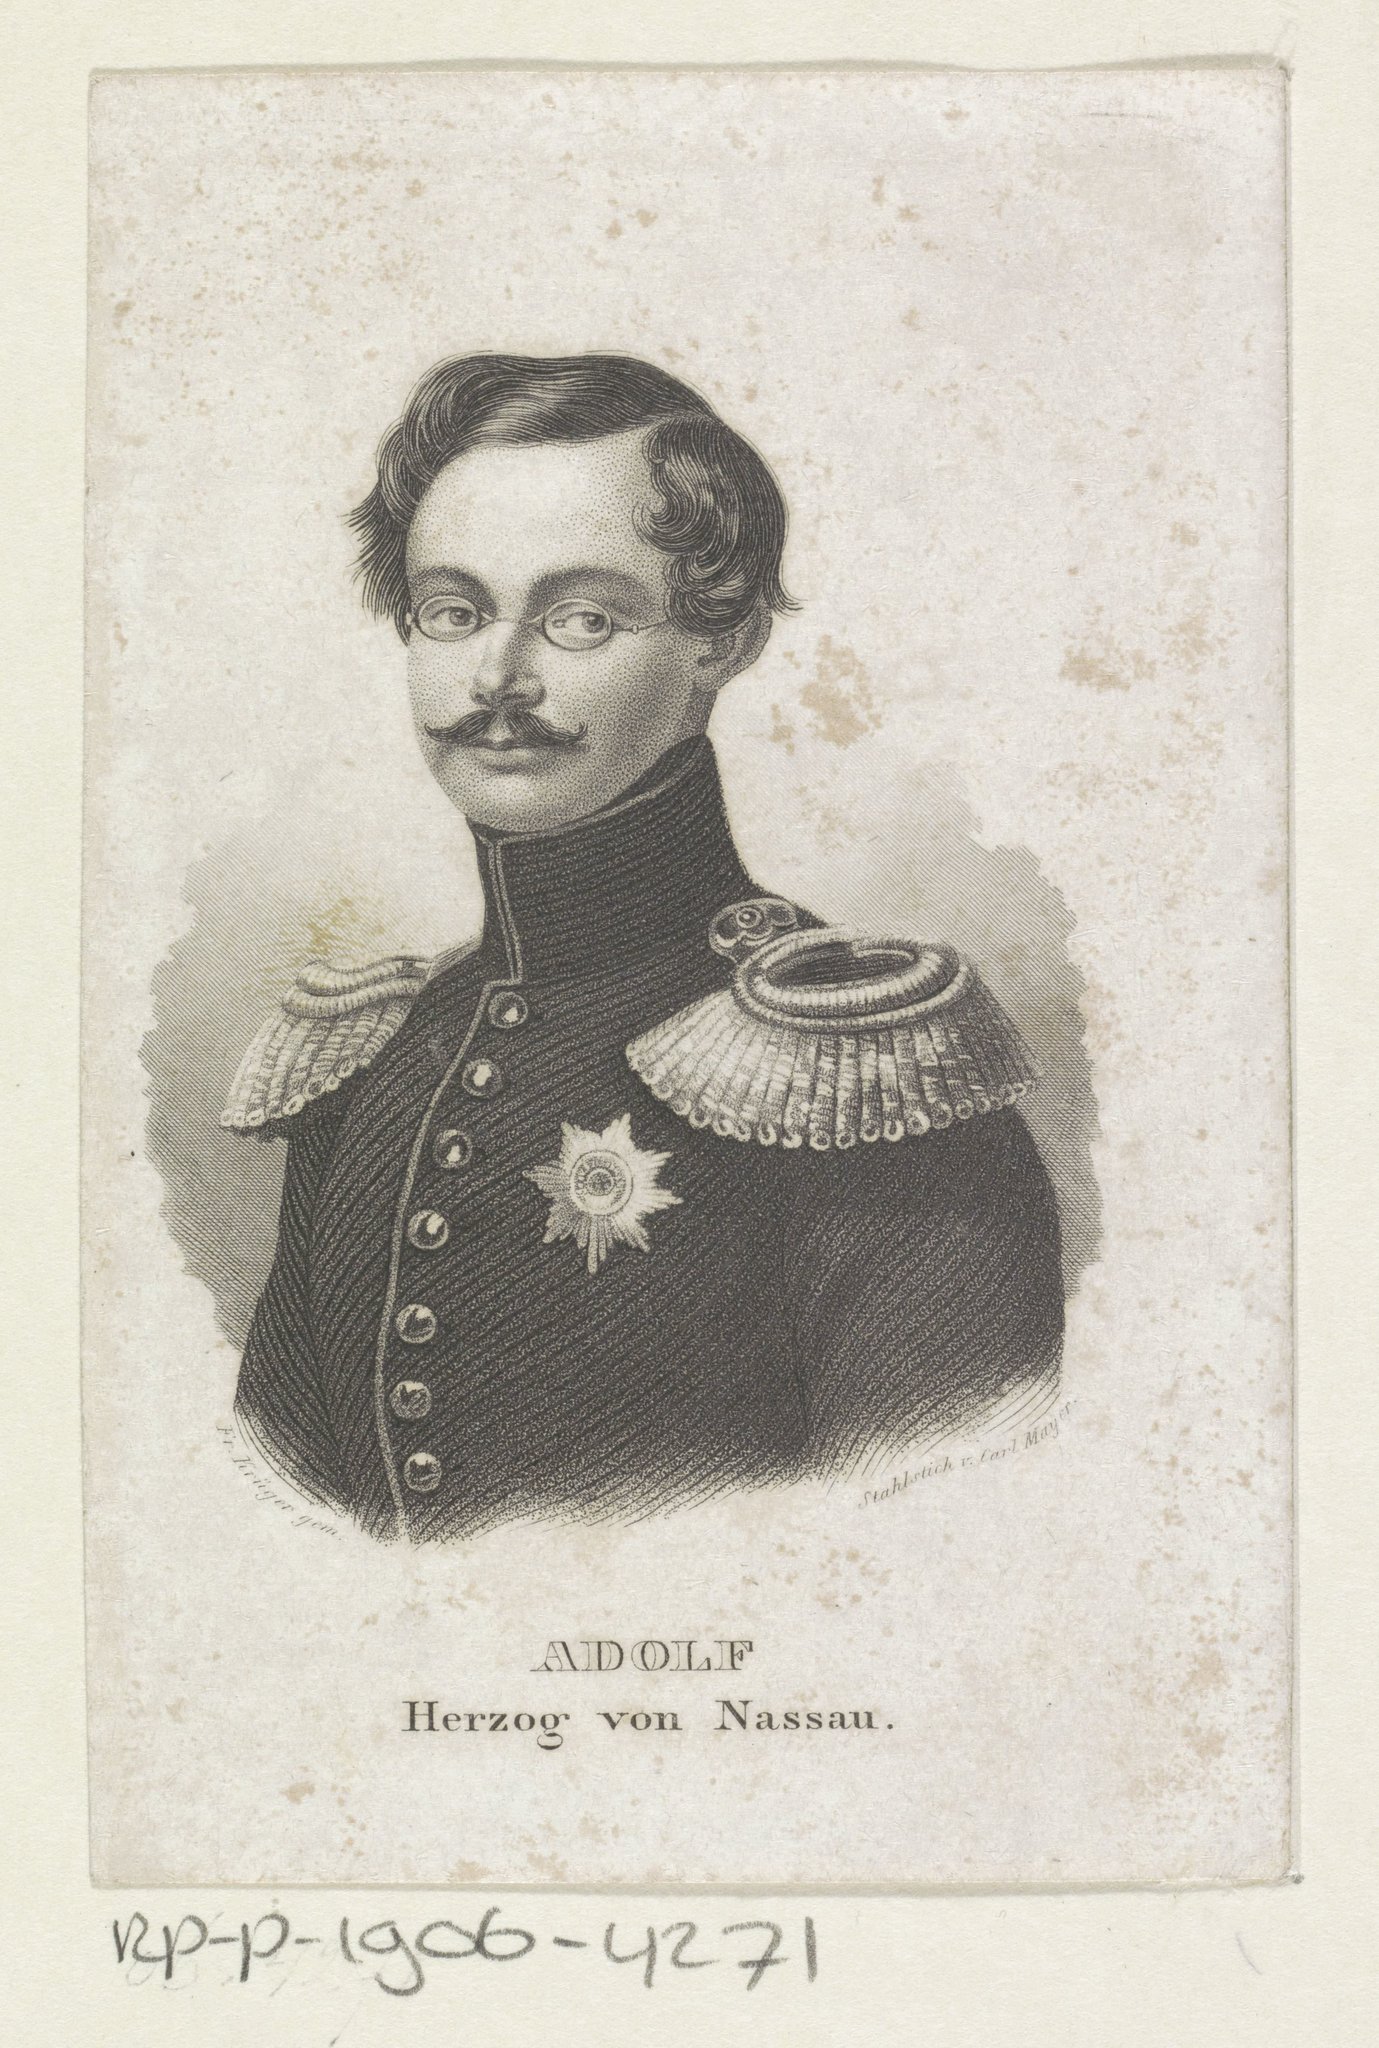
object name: print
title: Portret van Adolf van Nassau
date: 1835-1868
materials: paper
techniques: engraving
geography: nuremberg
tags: adolf van nassau, huis nassau walramse linie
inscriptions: collector's mark: Lugt 2228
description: Portret van Adolf. In de ondermarge zijn naam en titel in het Duits.